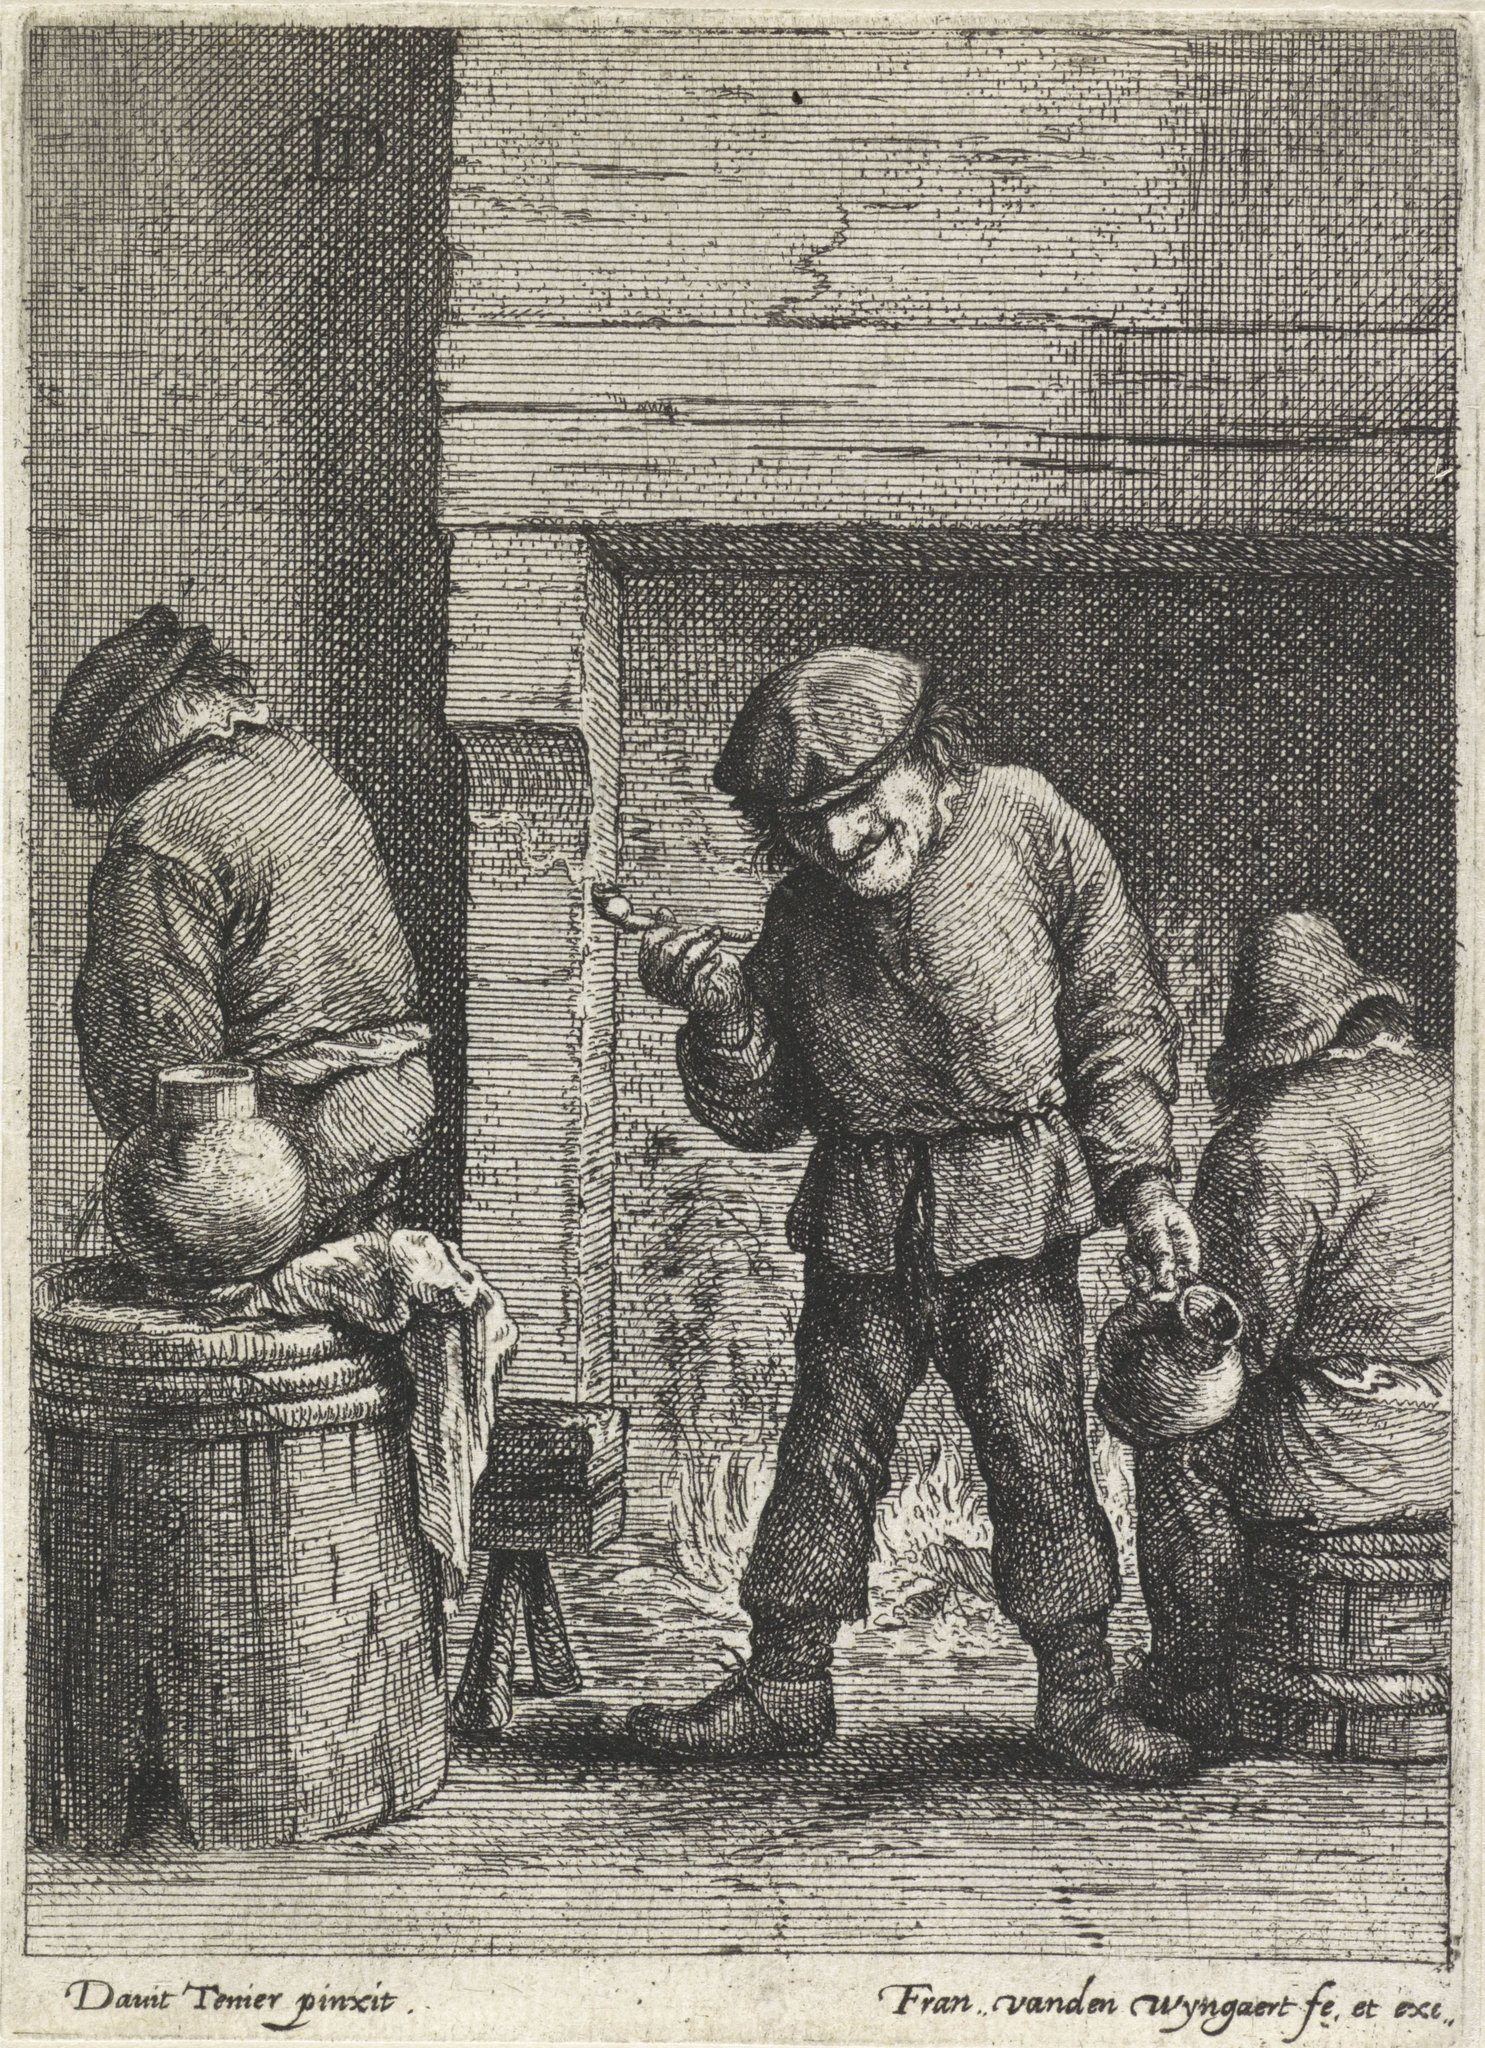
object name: print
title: Vier tijden van het etmaal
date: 1636-1679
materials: paper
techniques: etching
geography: antwerp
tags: pipe ~ tobacco, farmers, urination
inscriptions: collector's mark: Lugt 2228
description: Verbeelding van de avond: drie boeren bij een open haard in een herberg. Eén van hen plast tegen de muur aan.